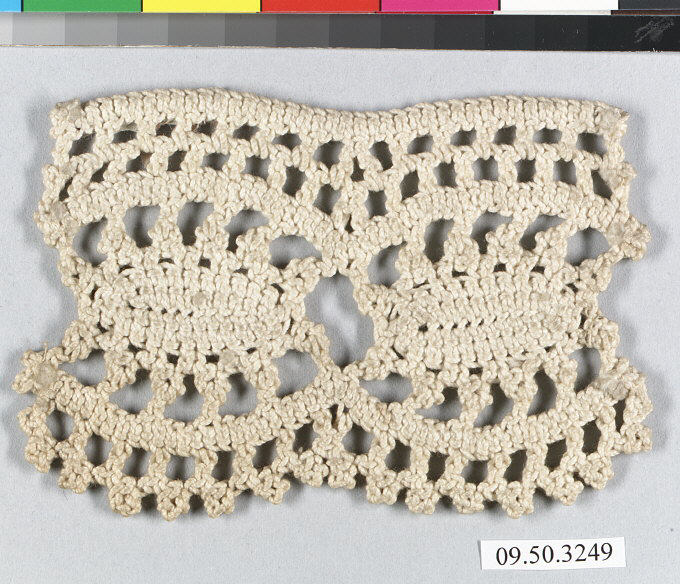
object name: sample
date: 1801-1900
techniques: crochet